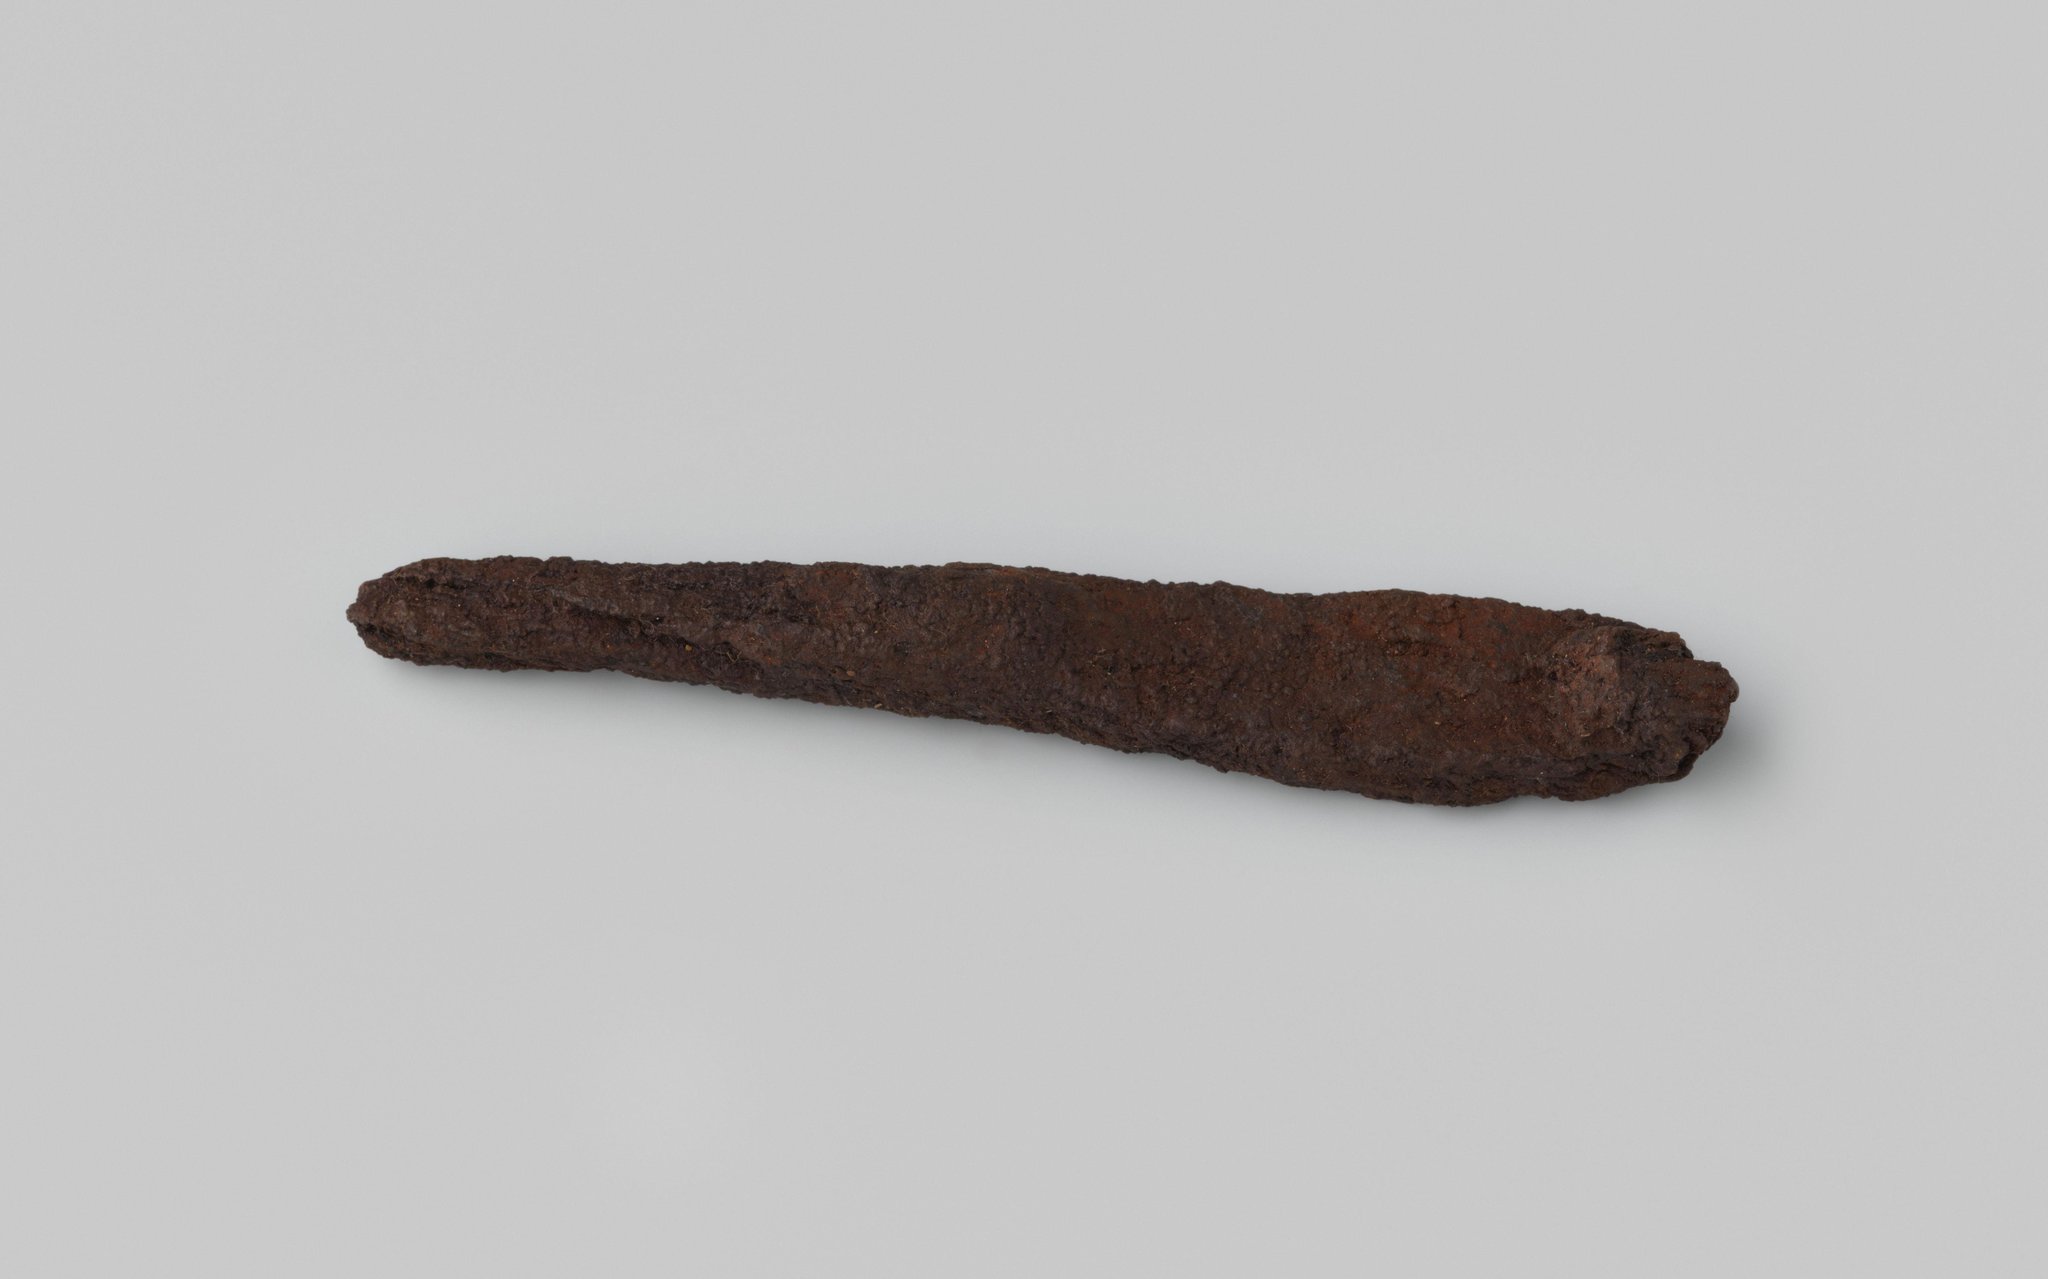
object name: wedge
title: Wig uit het wrak van de Oost-Indiëvaarder Hollandia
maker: Anonymous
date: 1700-1743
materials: iron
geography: netherlands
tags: verenigde oostindische compagnie, hollandia (schip), annet